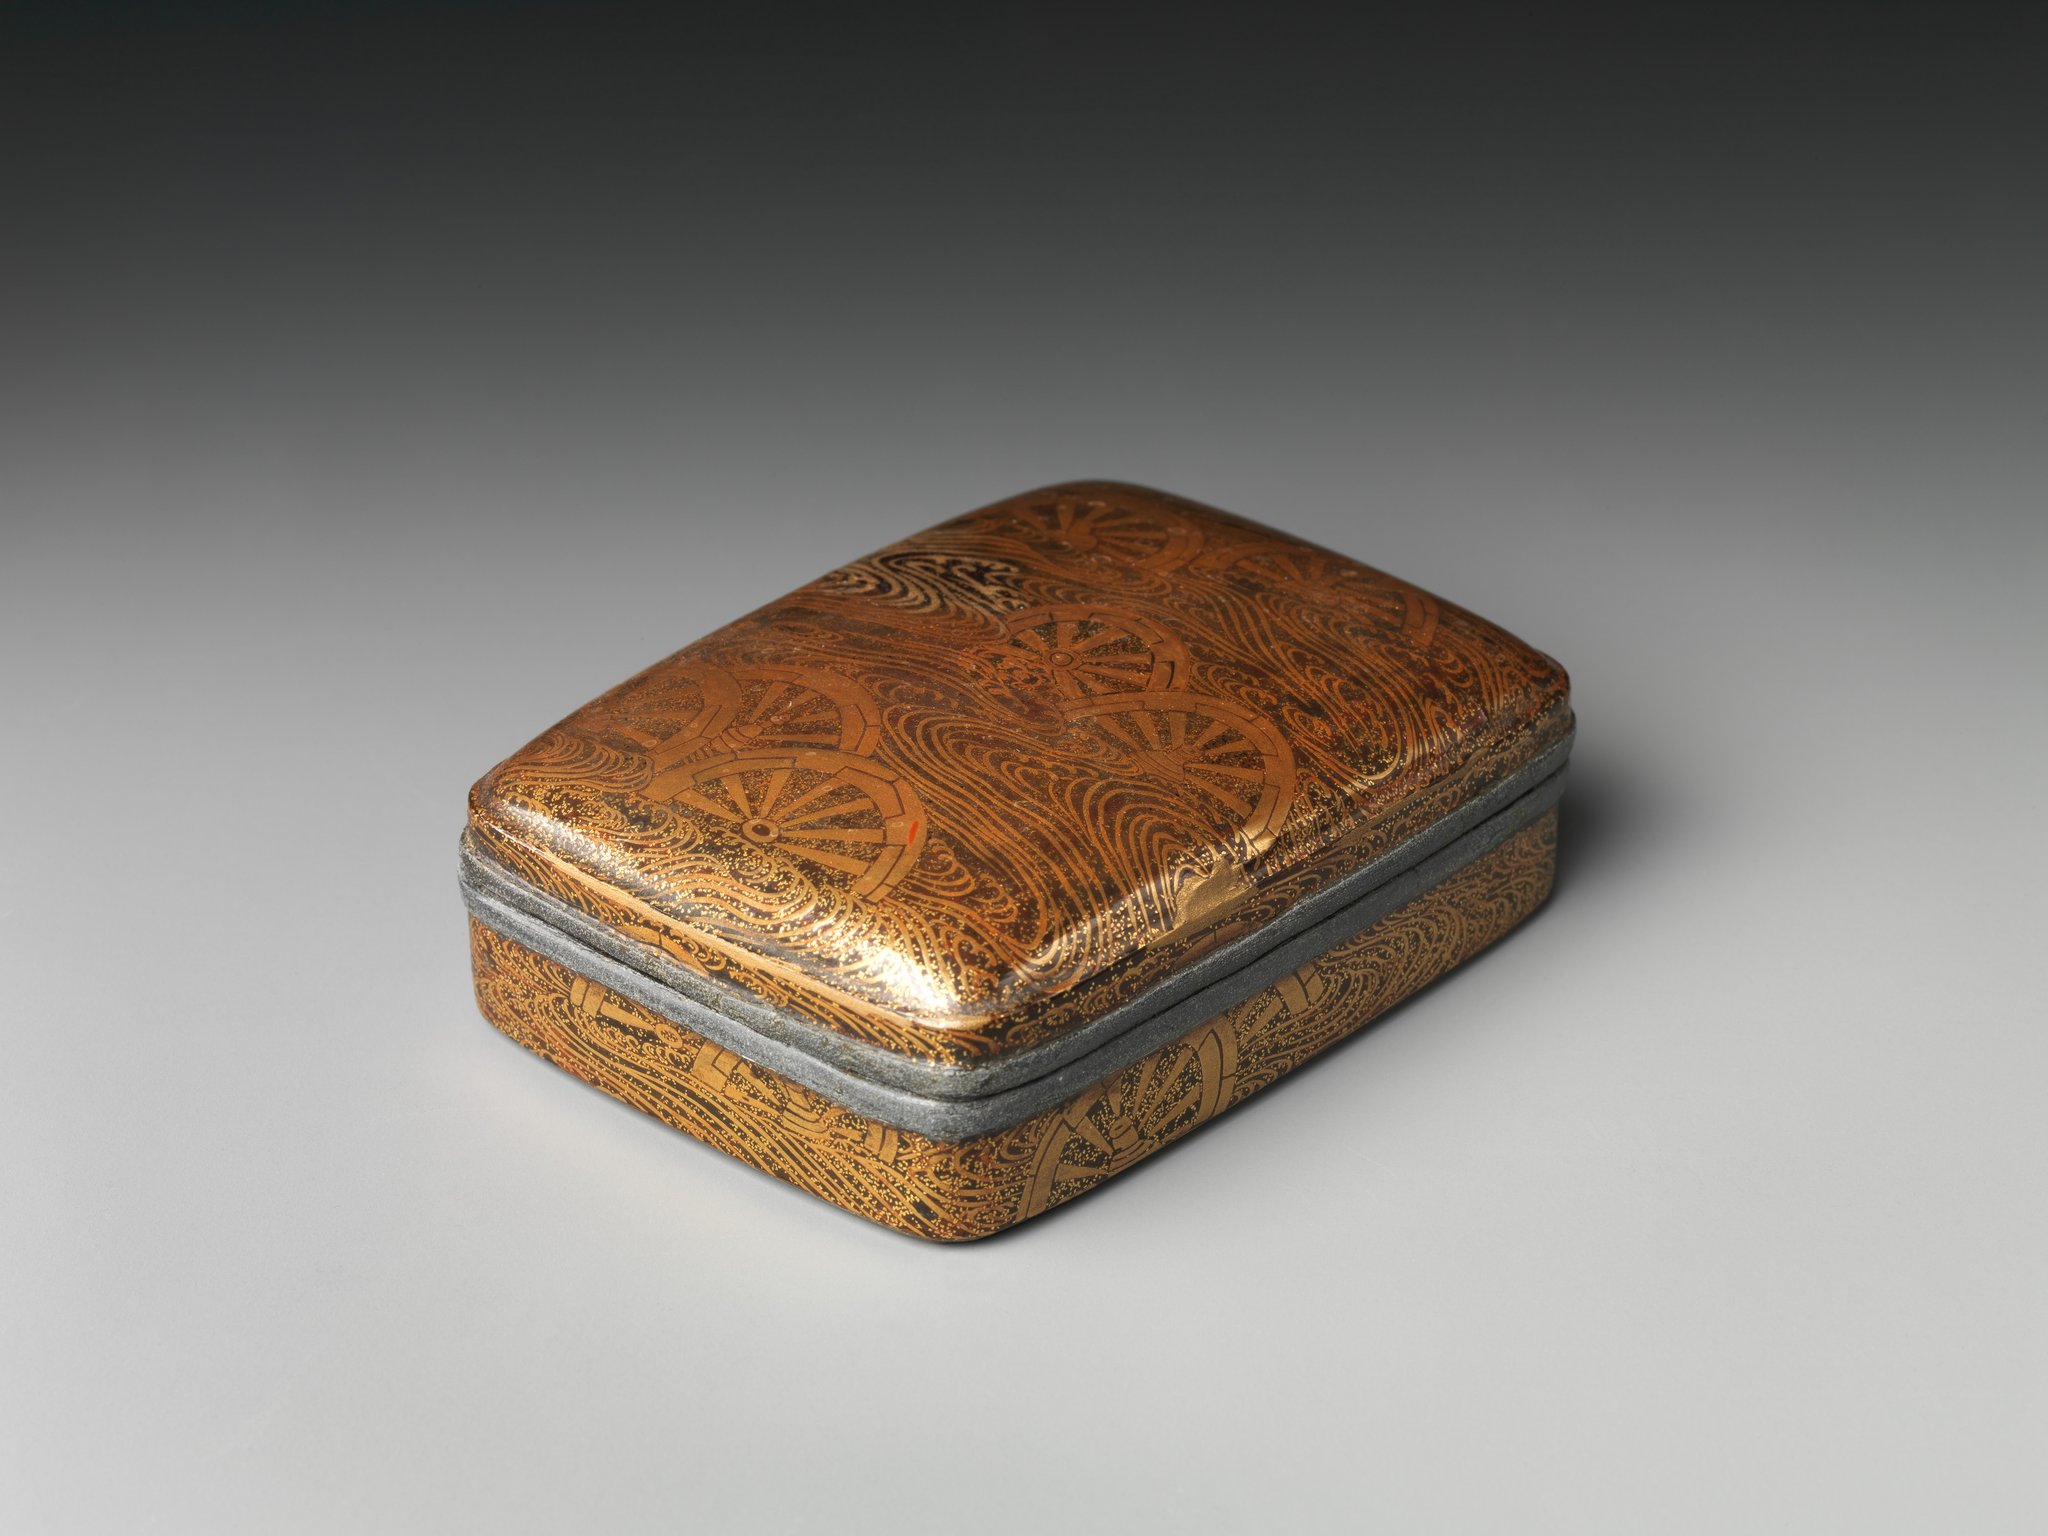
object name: box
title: Incense Box (Kōgō) with Cartwheels Submerged in Water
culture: japanese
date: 1401-1500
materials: gold, wood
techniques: hiramakie, lacquer